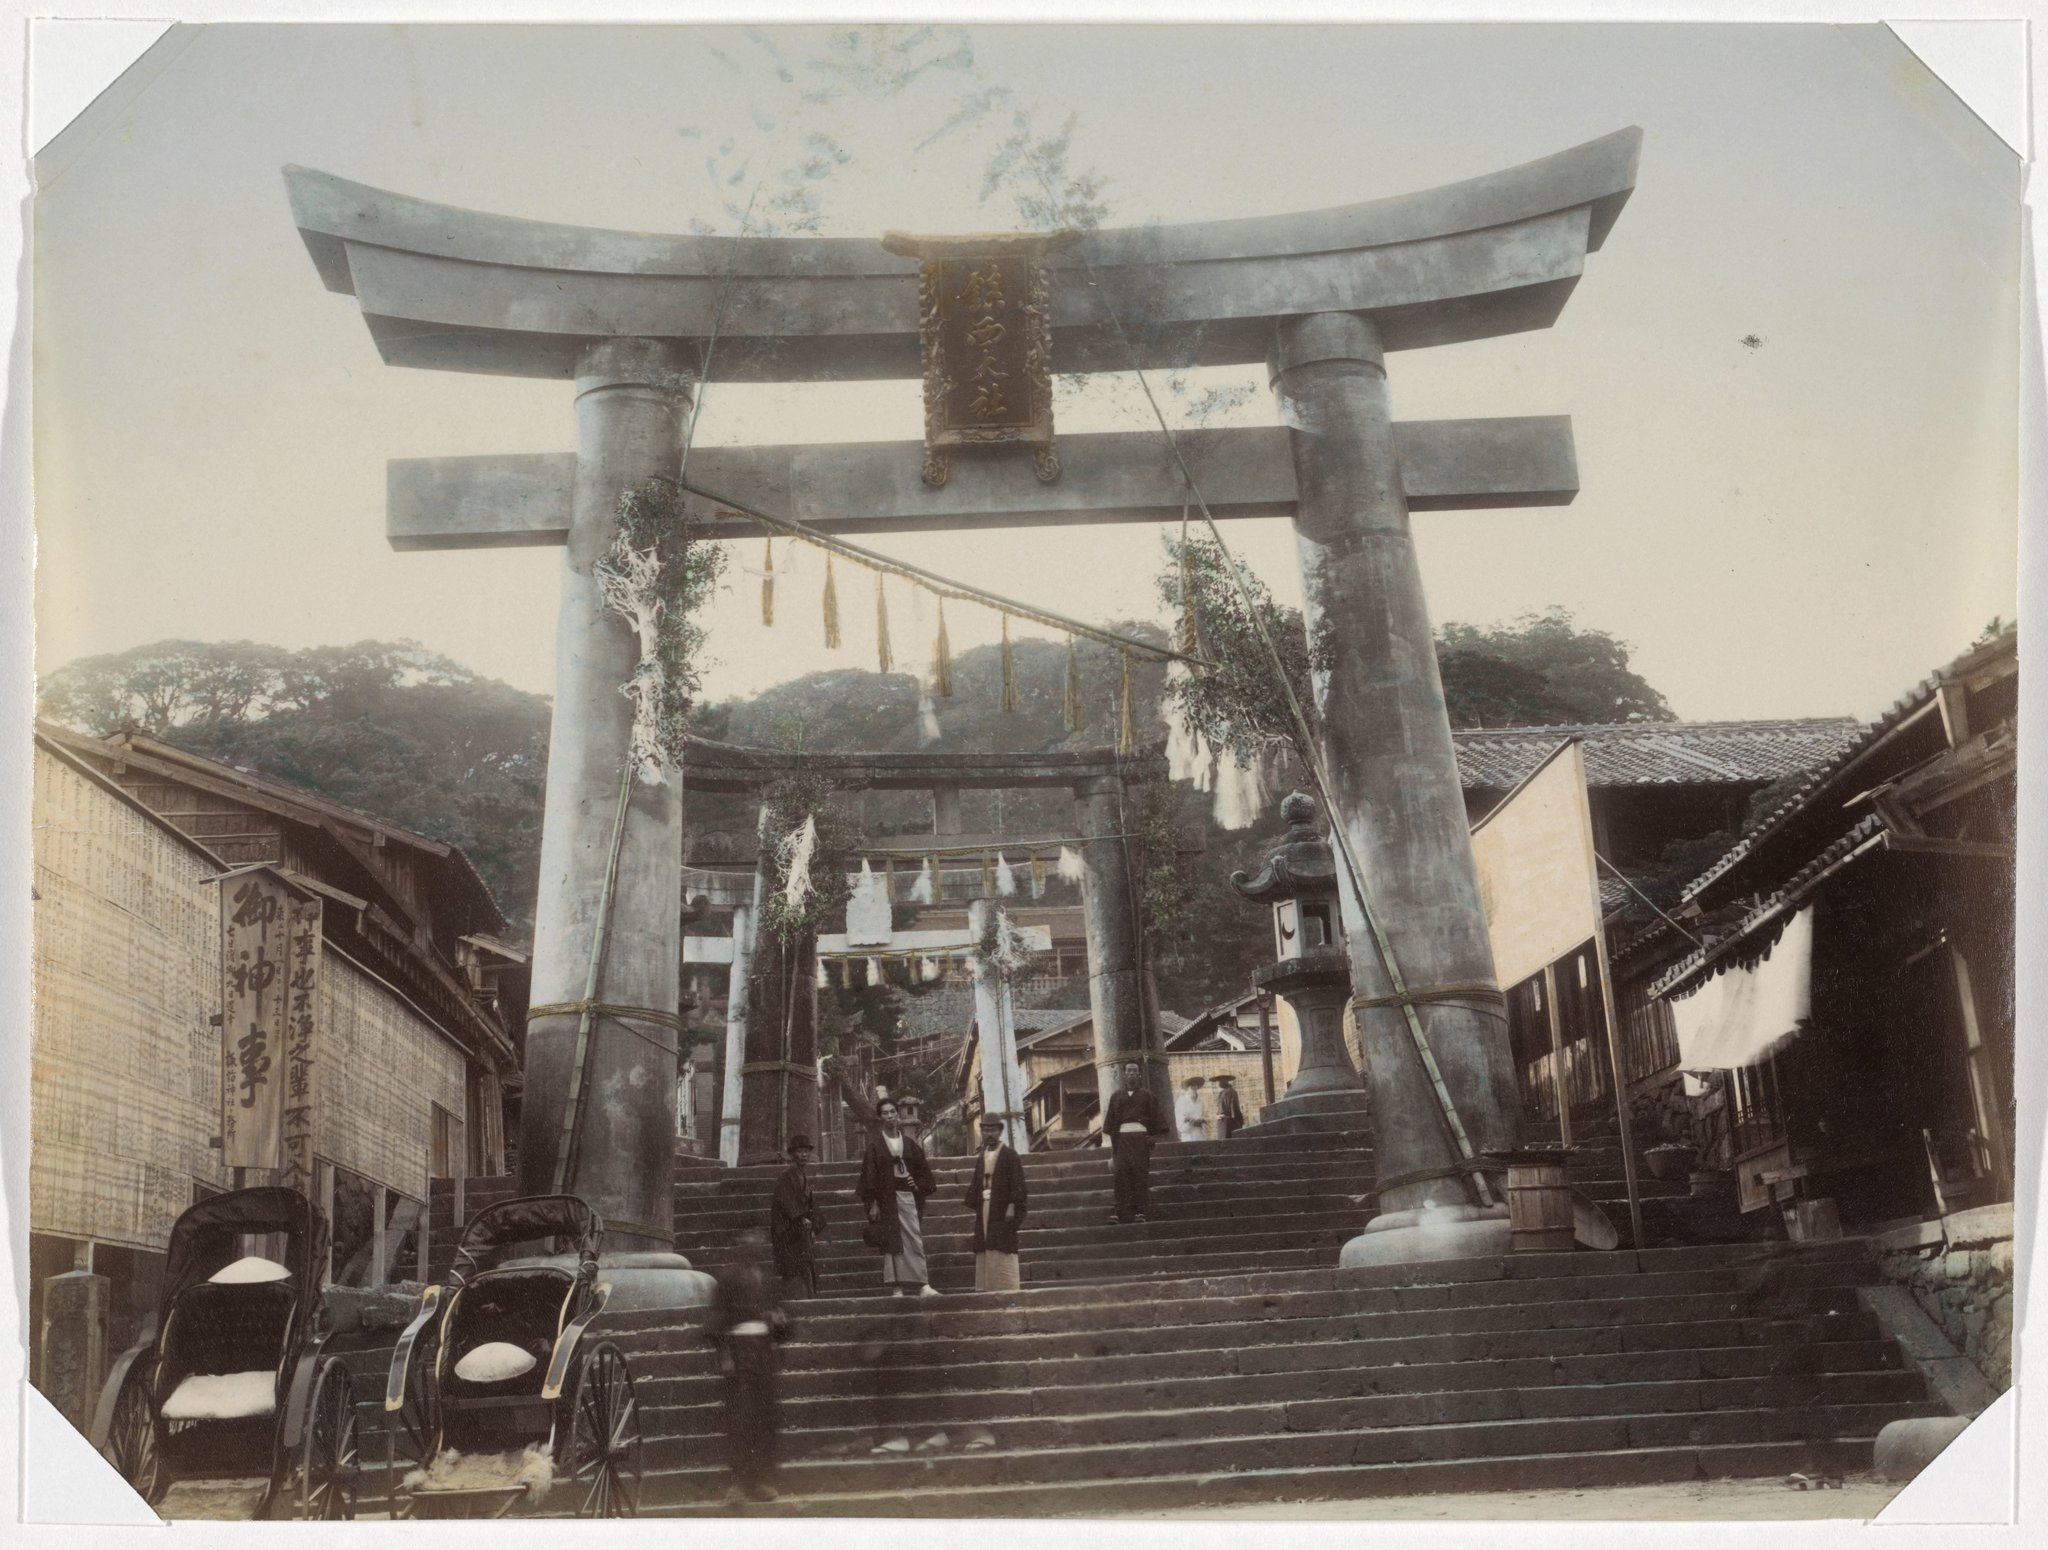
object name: photograph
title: Heilige poorten voor de ingang van tempels in Tokyo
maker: Anonymous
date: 1890-1894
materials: cardboard, paper, photographic support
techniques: albumen print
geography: tokyo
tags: temple, shrine ~ hinduism, buddhism, jainism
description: Onderdeel van Album met 69 foto's van een reis door Japan.